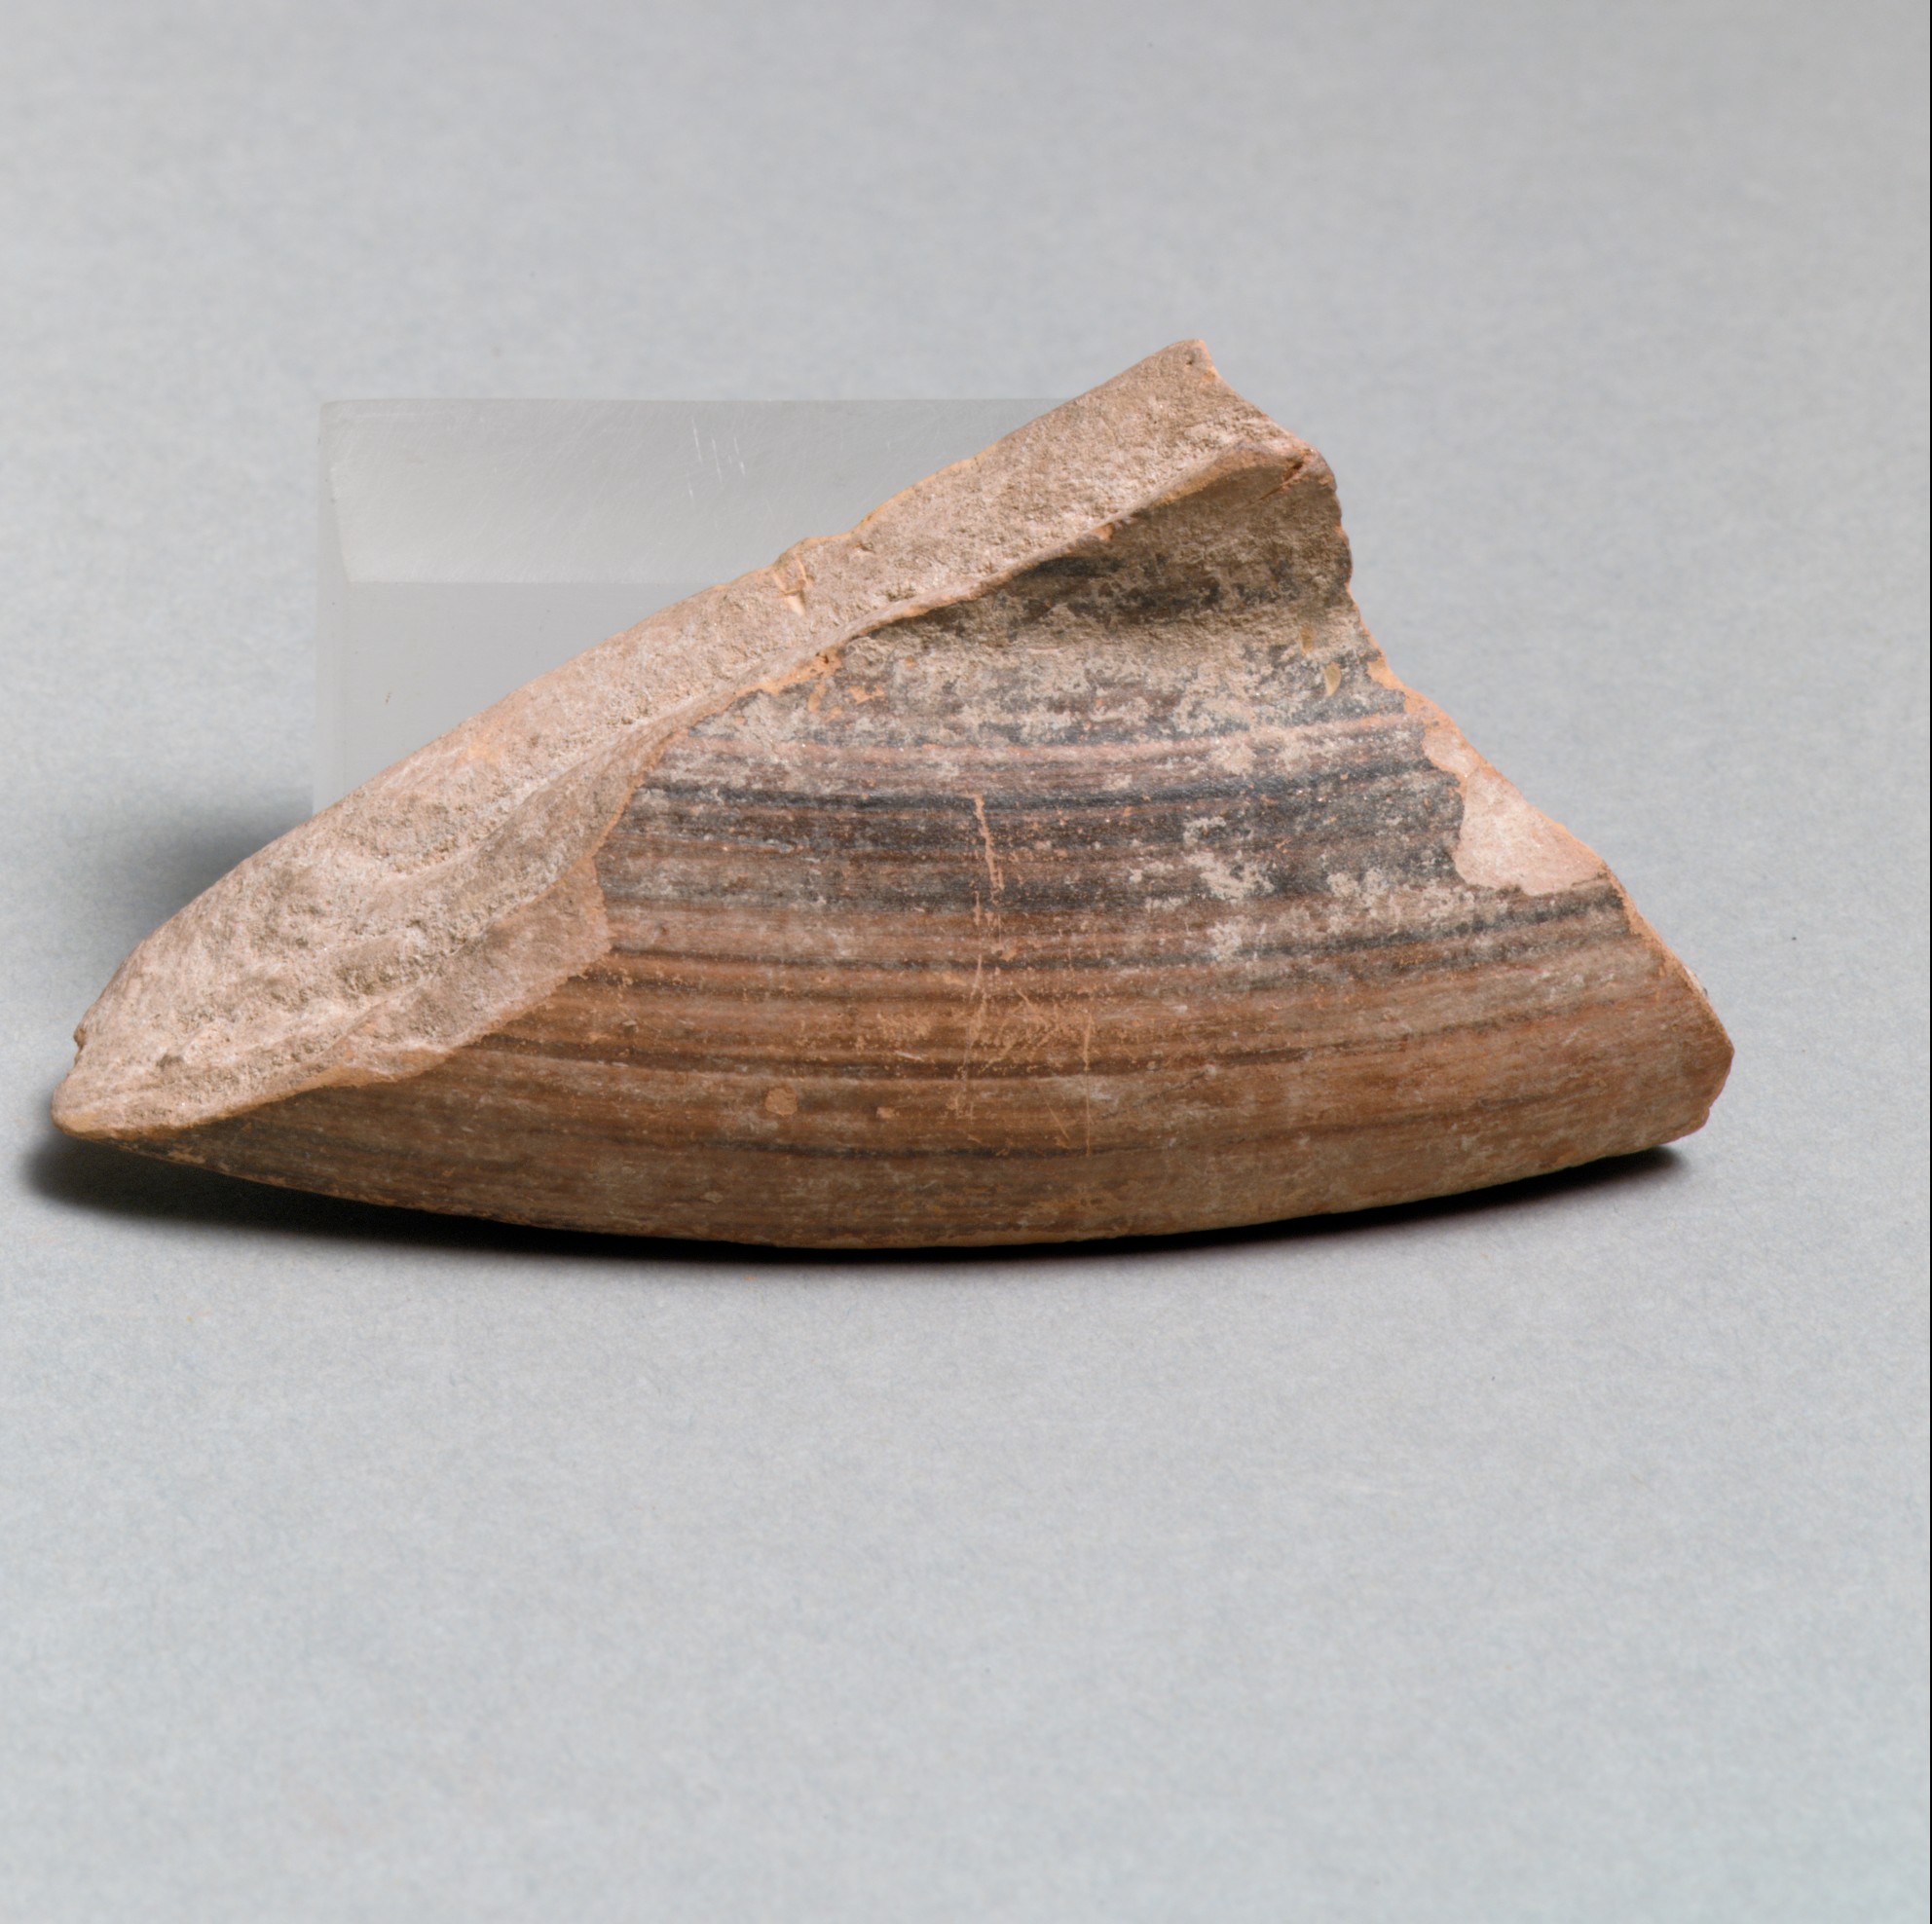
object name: vase fragment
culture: greek or lydian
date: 900-30 BCE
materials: terracotta